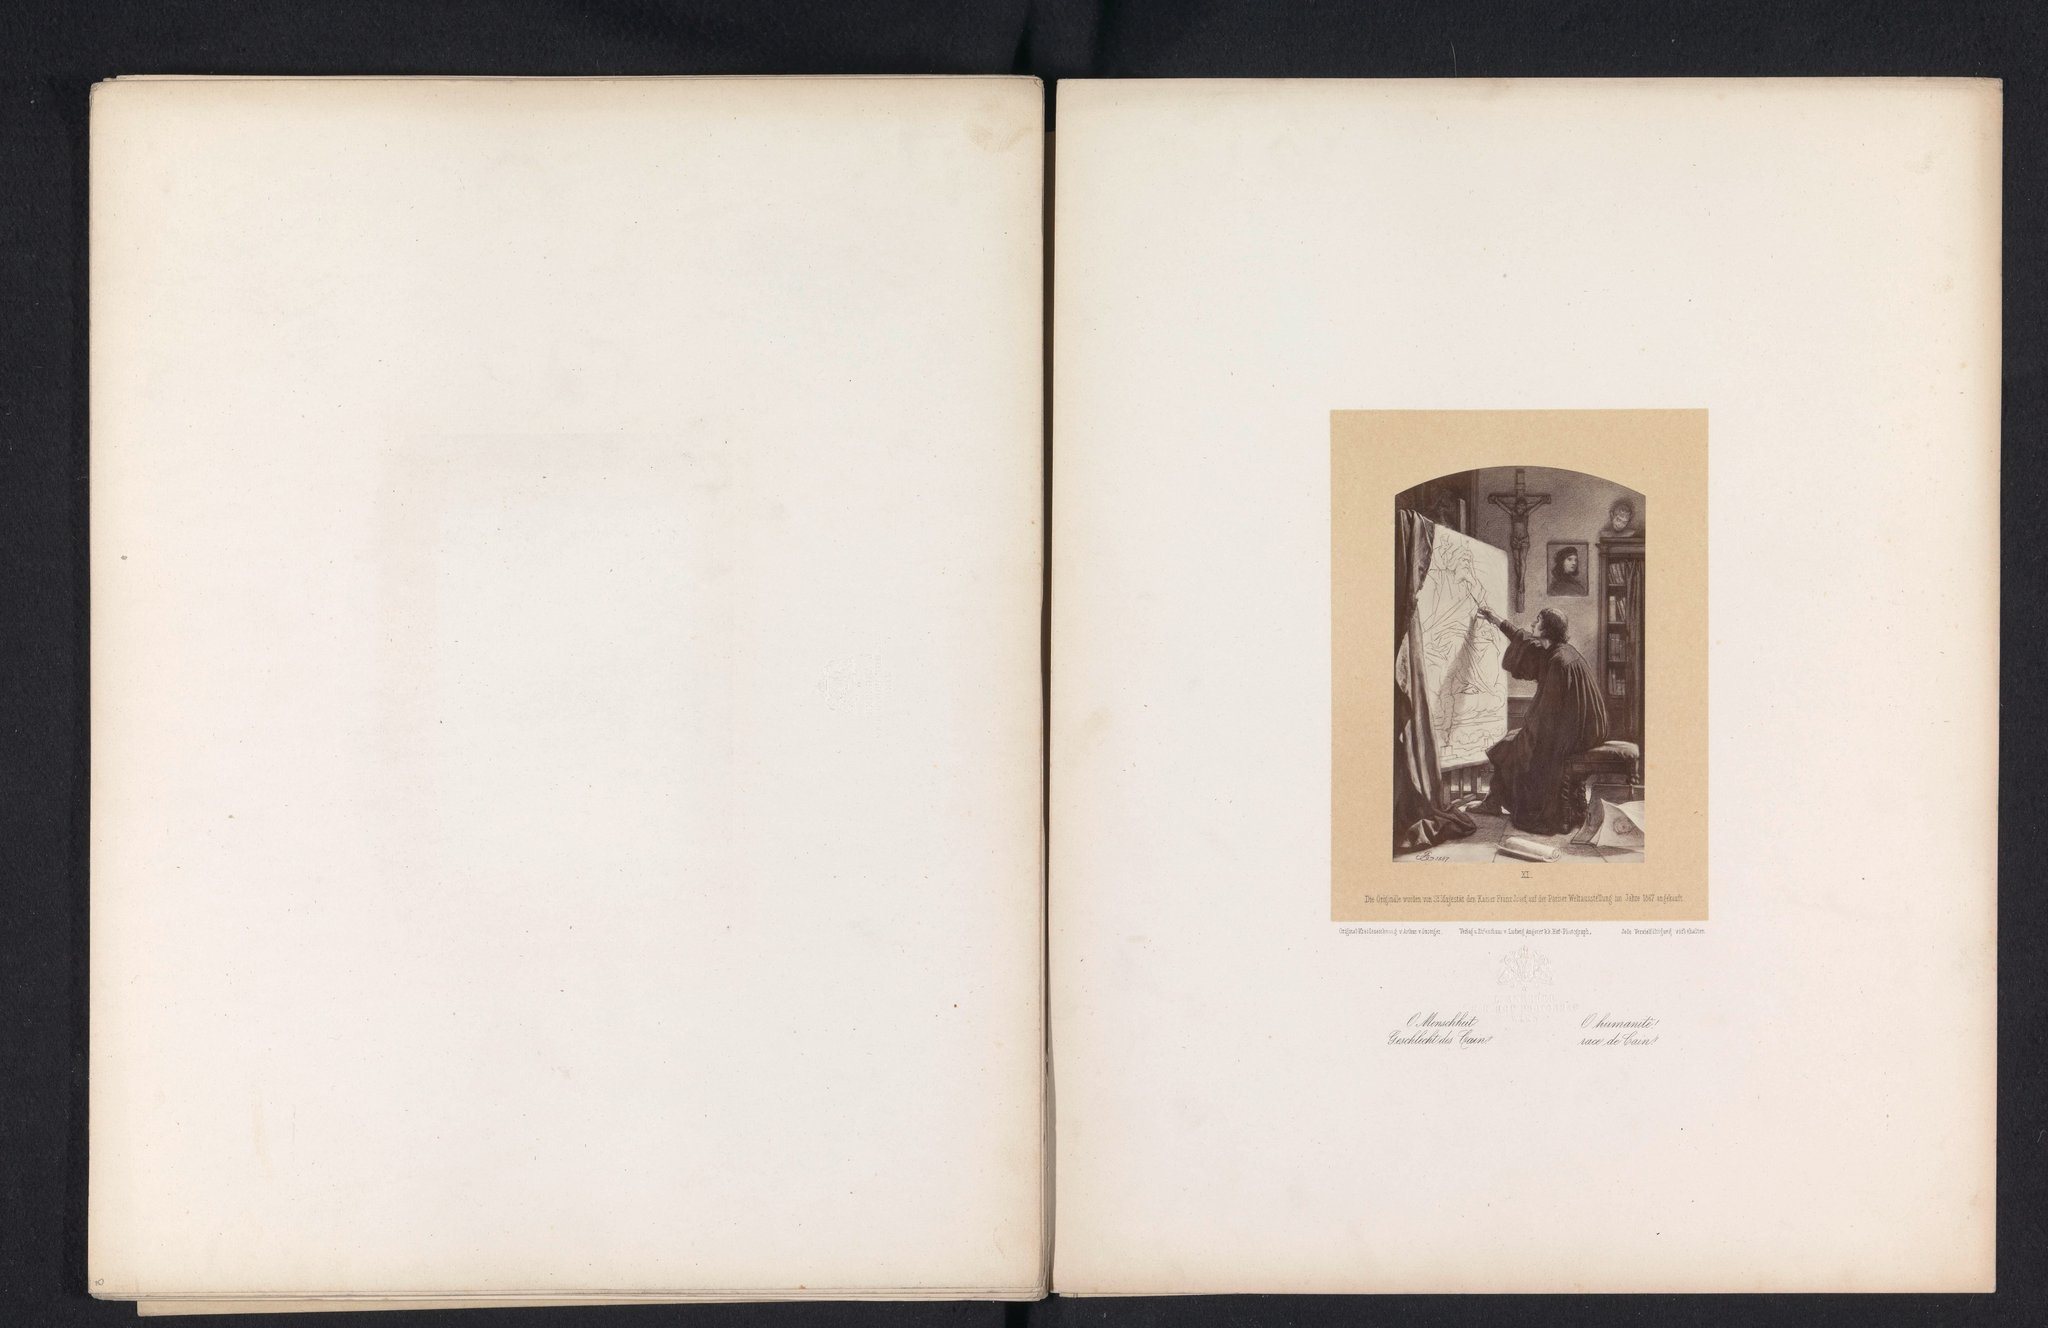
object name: reproduction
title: Fotoreproductie van een tekening van een man die een schilderij van God maakt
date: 1867-1868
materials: photographic support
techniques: albumen print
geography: vienna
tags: workshop, studio ~ painter, artist (in general)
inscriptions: number: ‘XI.’, inscription: ‘Die Originale wurden von Sr Majestat den Kaiser Franz Josef auf der Pariser Weltausstellung im Jahre 1867 angekauft.’